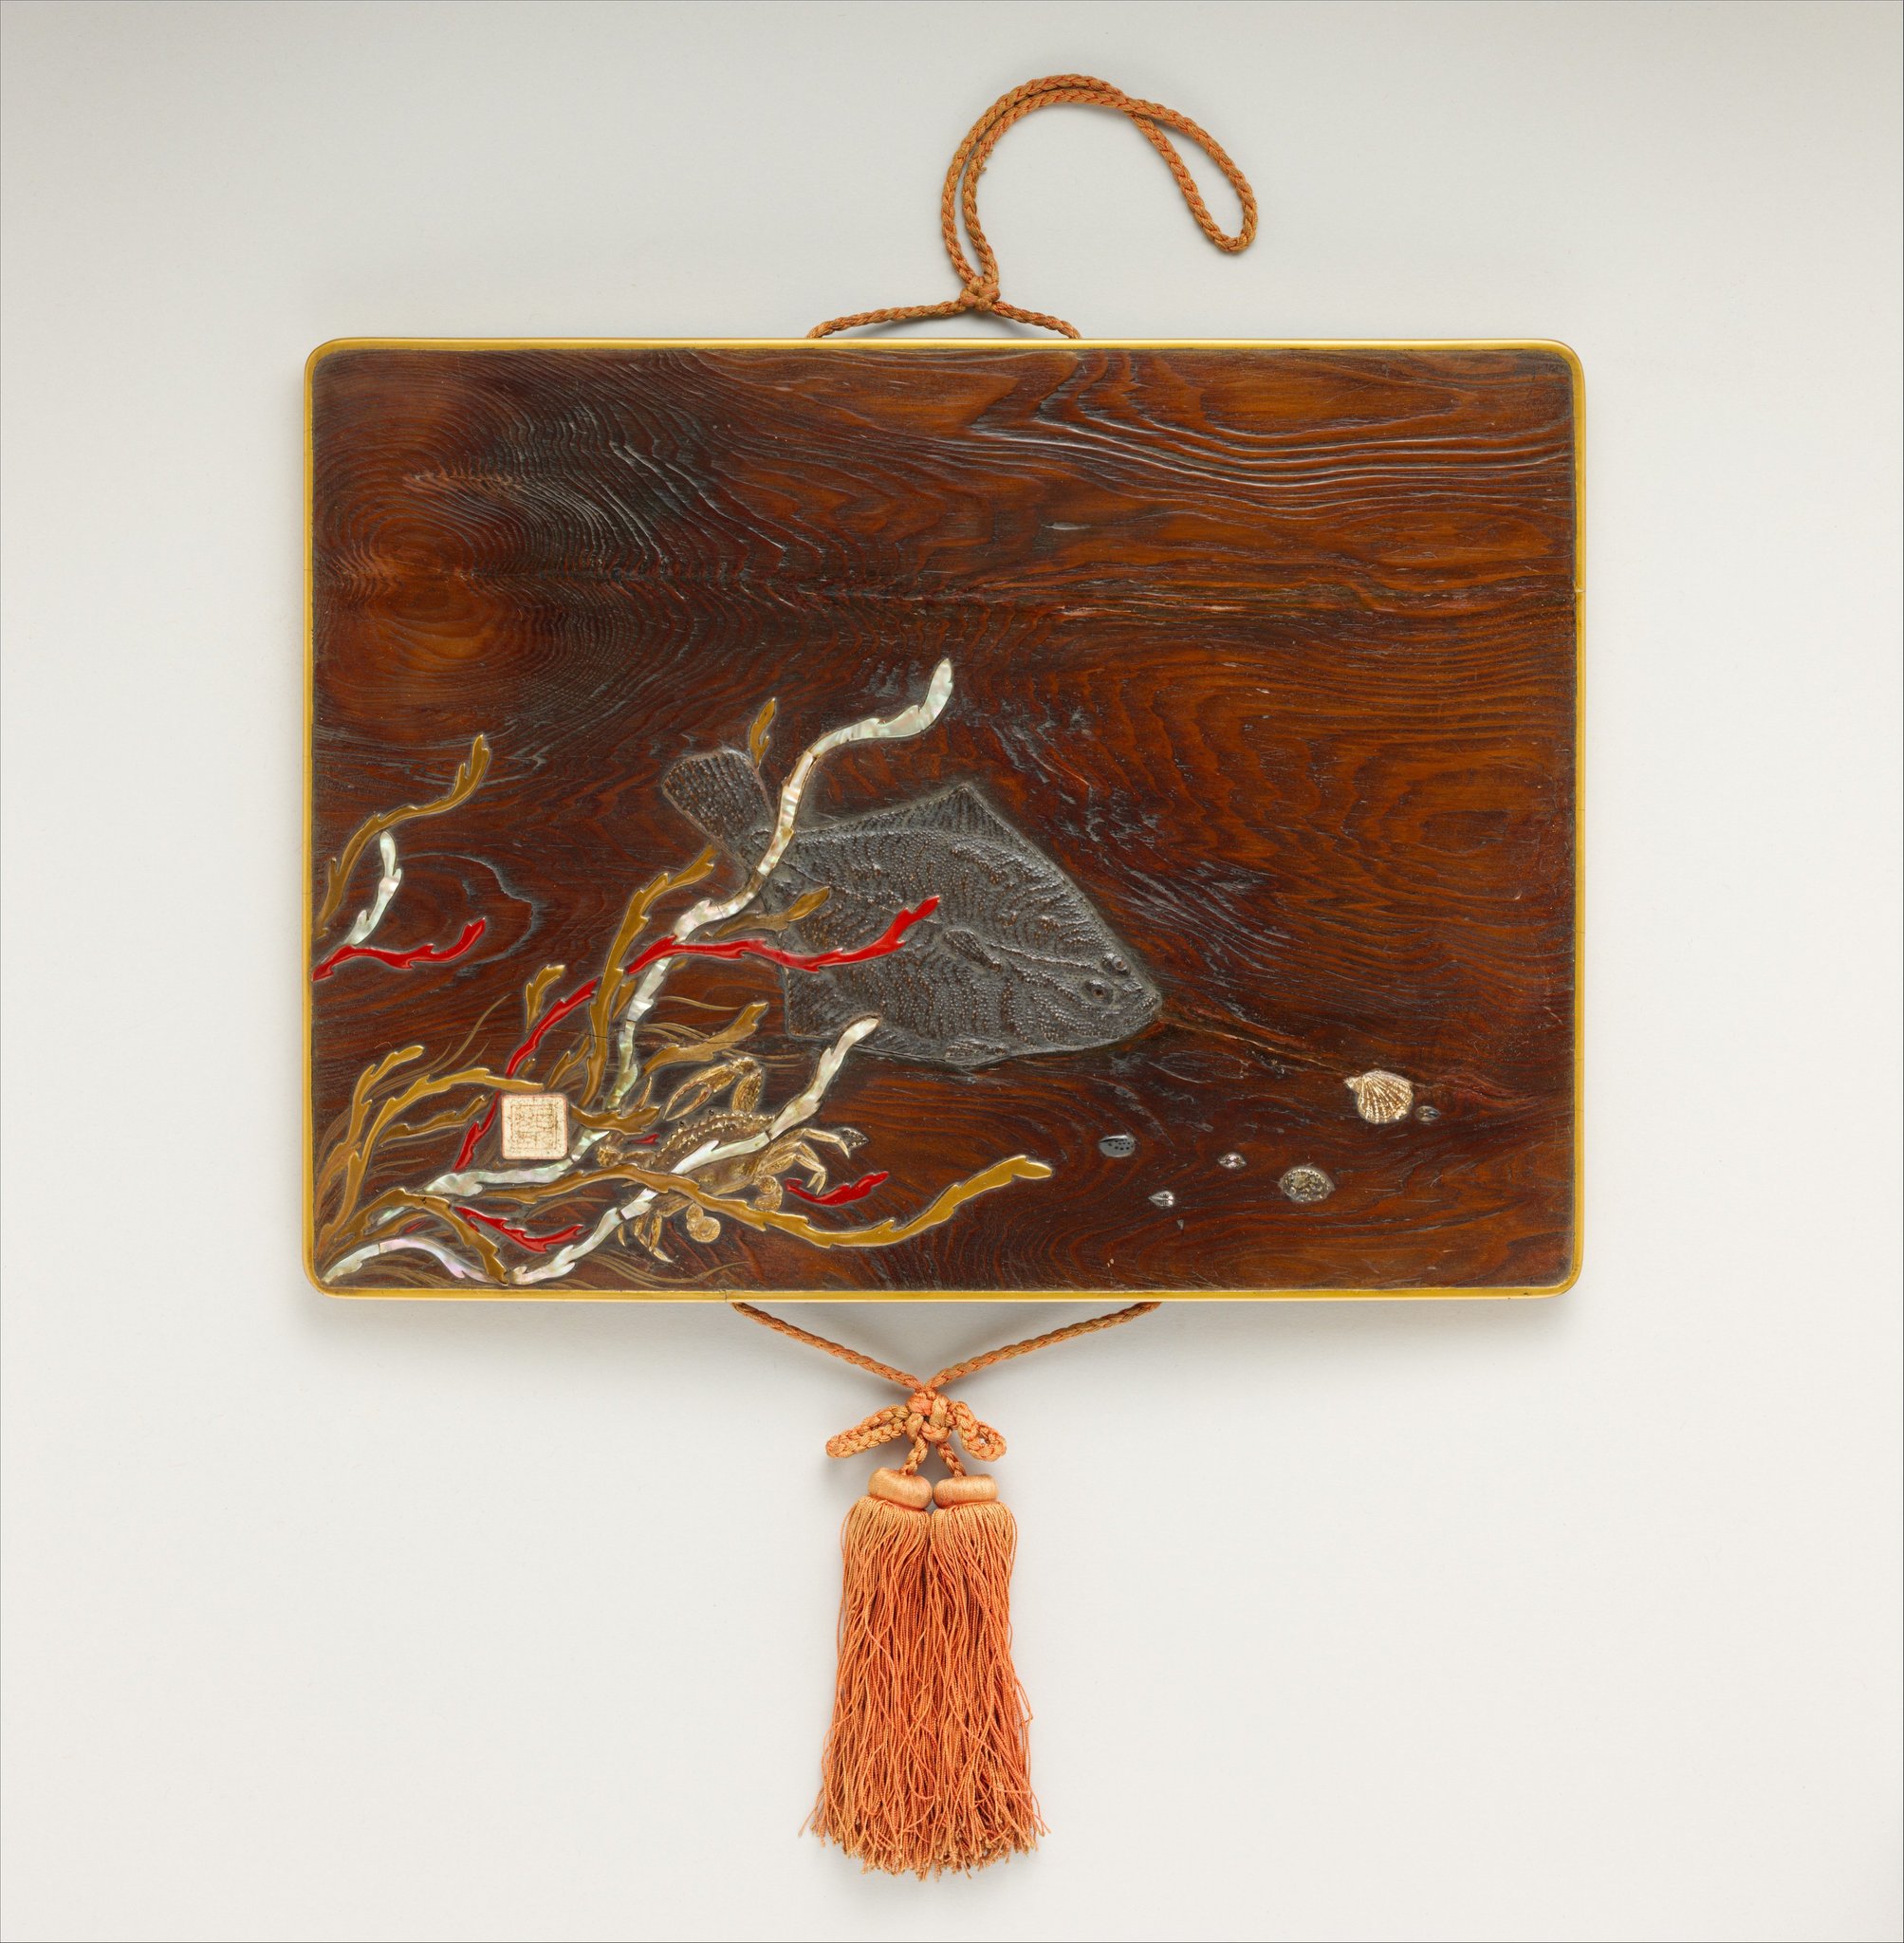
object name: panel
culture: japanese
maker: ogawa haritsu (ritsuō)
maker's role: artist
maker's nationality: japanese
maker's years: 1663-1747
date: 1701-1800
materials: wood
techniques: lacquer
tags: fish